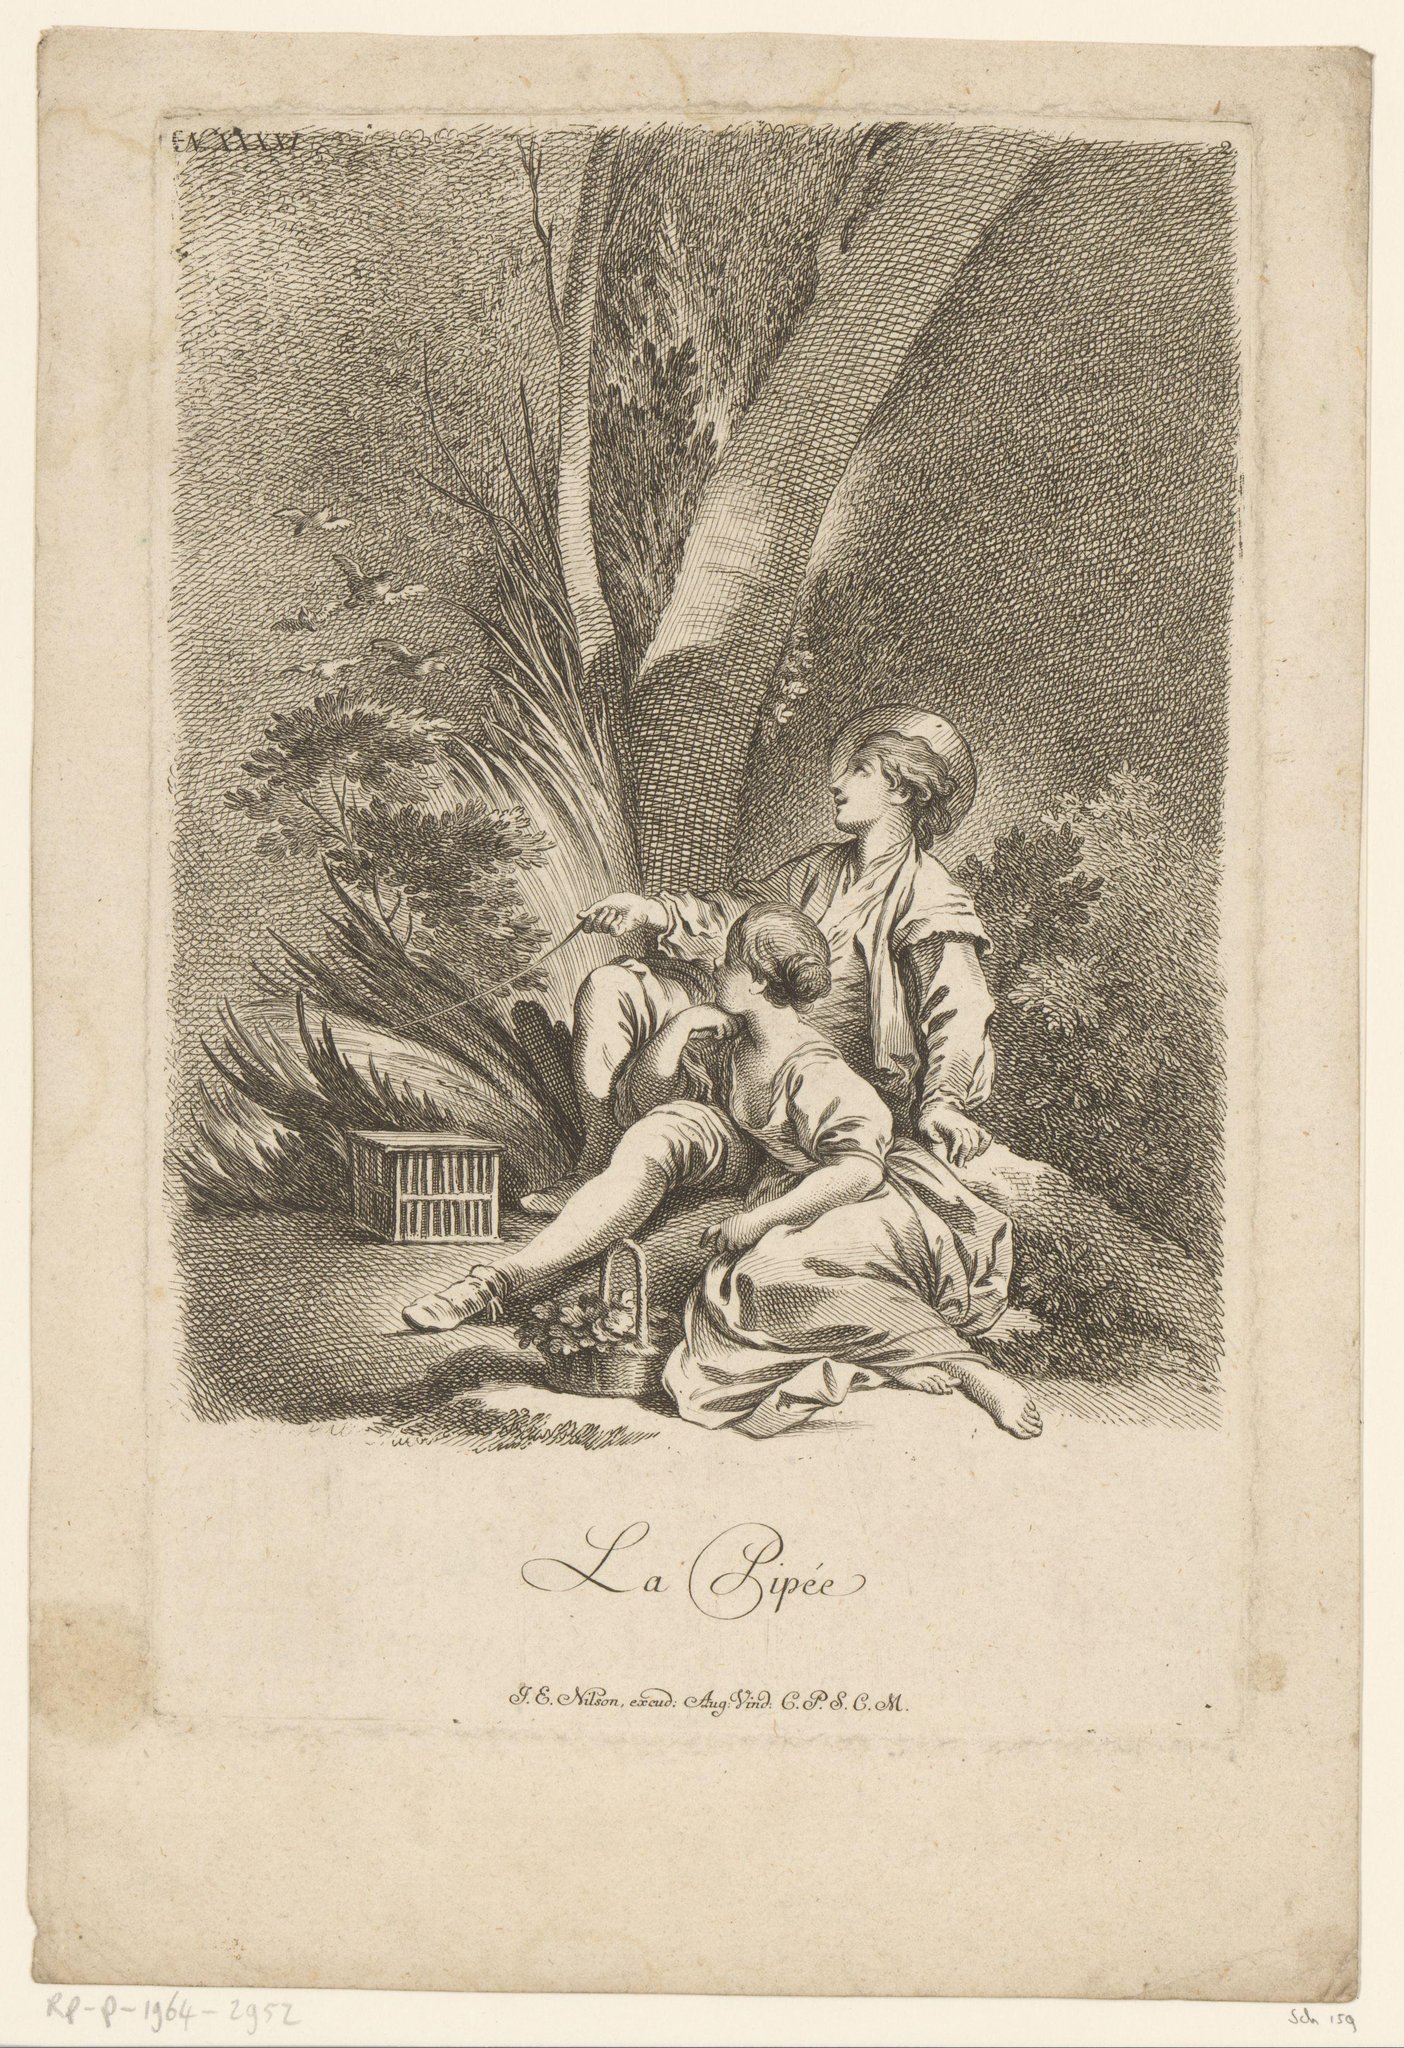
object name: print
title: Jong stel vogelkooi in een bos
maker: johann esaias nilson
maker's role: draughtsman, print maker, publisher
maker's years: 1721-1788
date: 1731-1788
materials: paper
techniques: engraving, etching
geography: augsburg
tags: empty bird cage, couple of lovers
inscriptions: collector's mark: Lugt 2228, collector's mark: Lugt 2760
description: Linksboven gedrukt nummer XXXXI en rechtsboven 2.